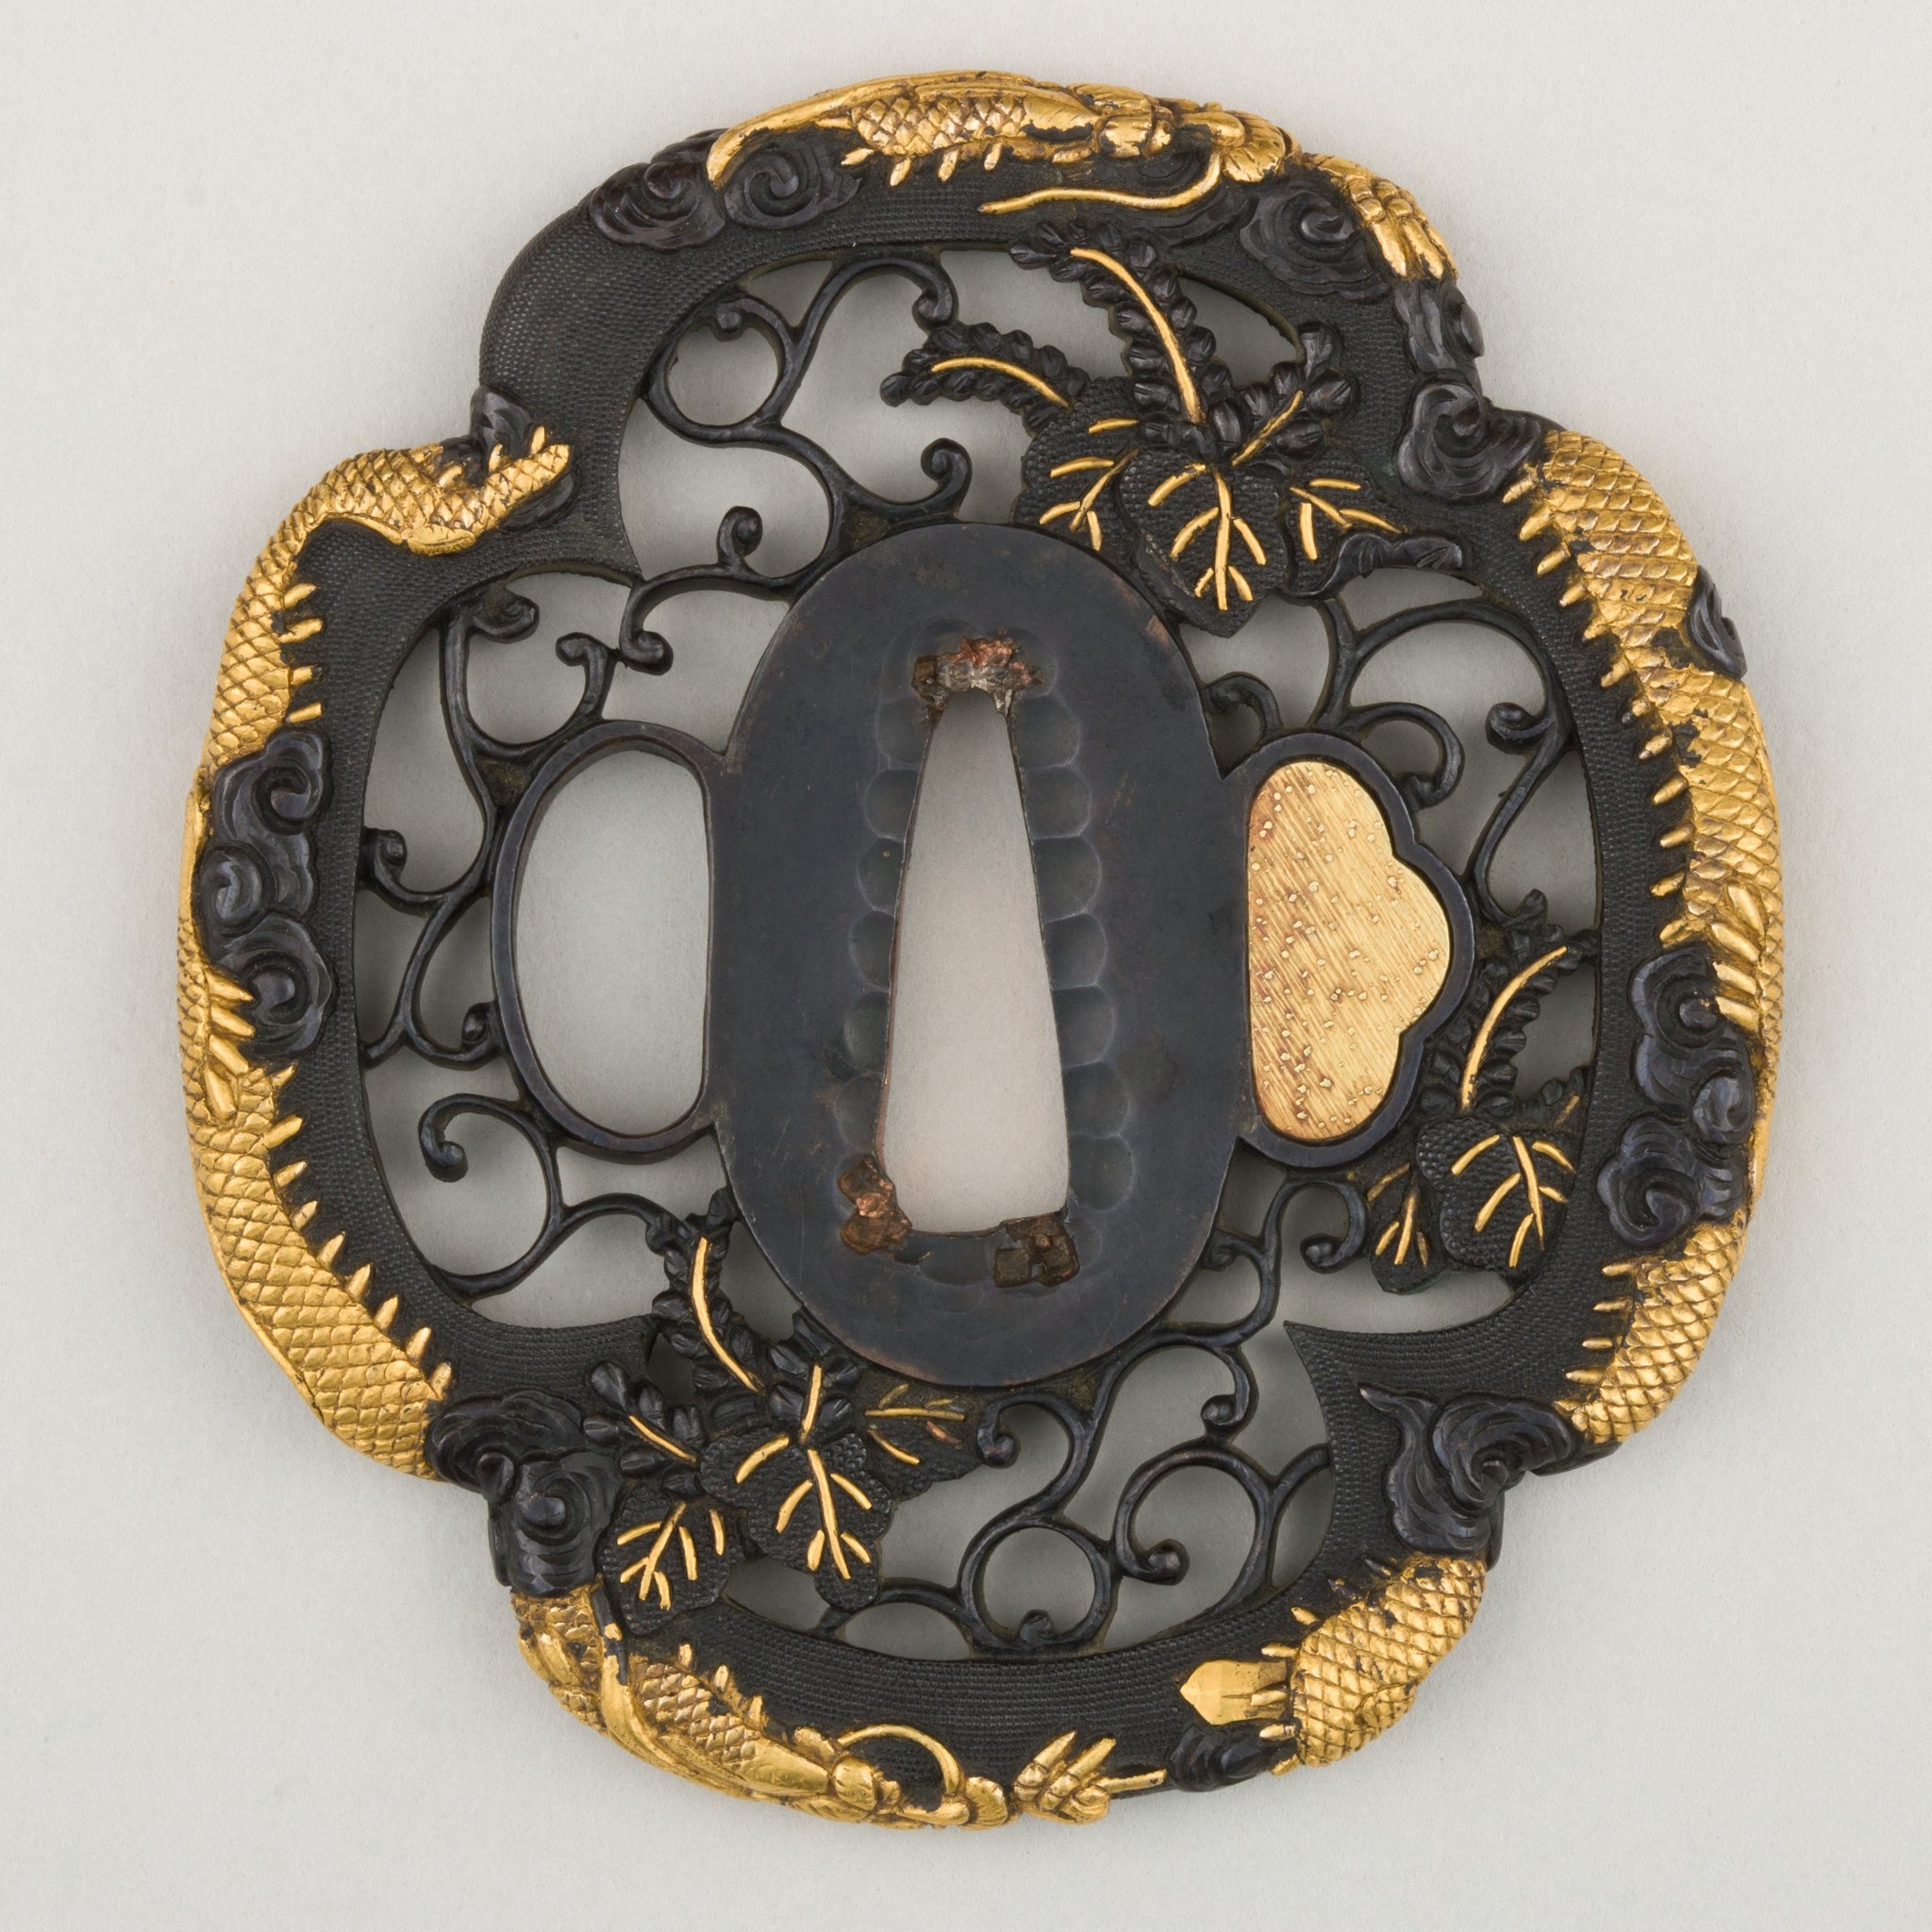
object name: sword guard tsuba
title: Sword Guard (Tsuba)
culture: japanese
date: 1801-1833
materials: copper, gold alloy, gold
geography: japan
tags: dragons